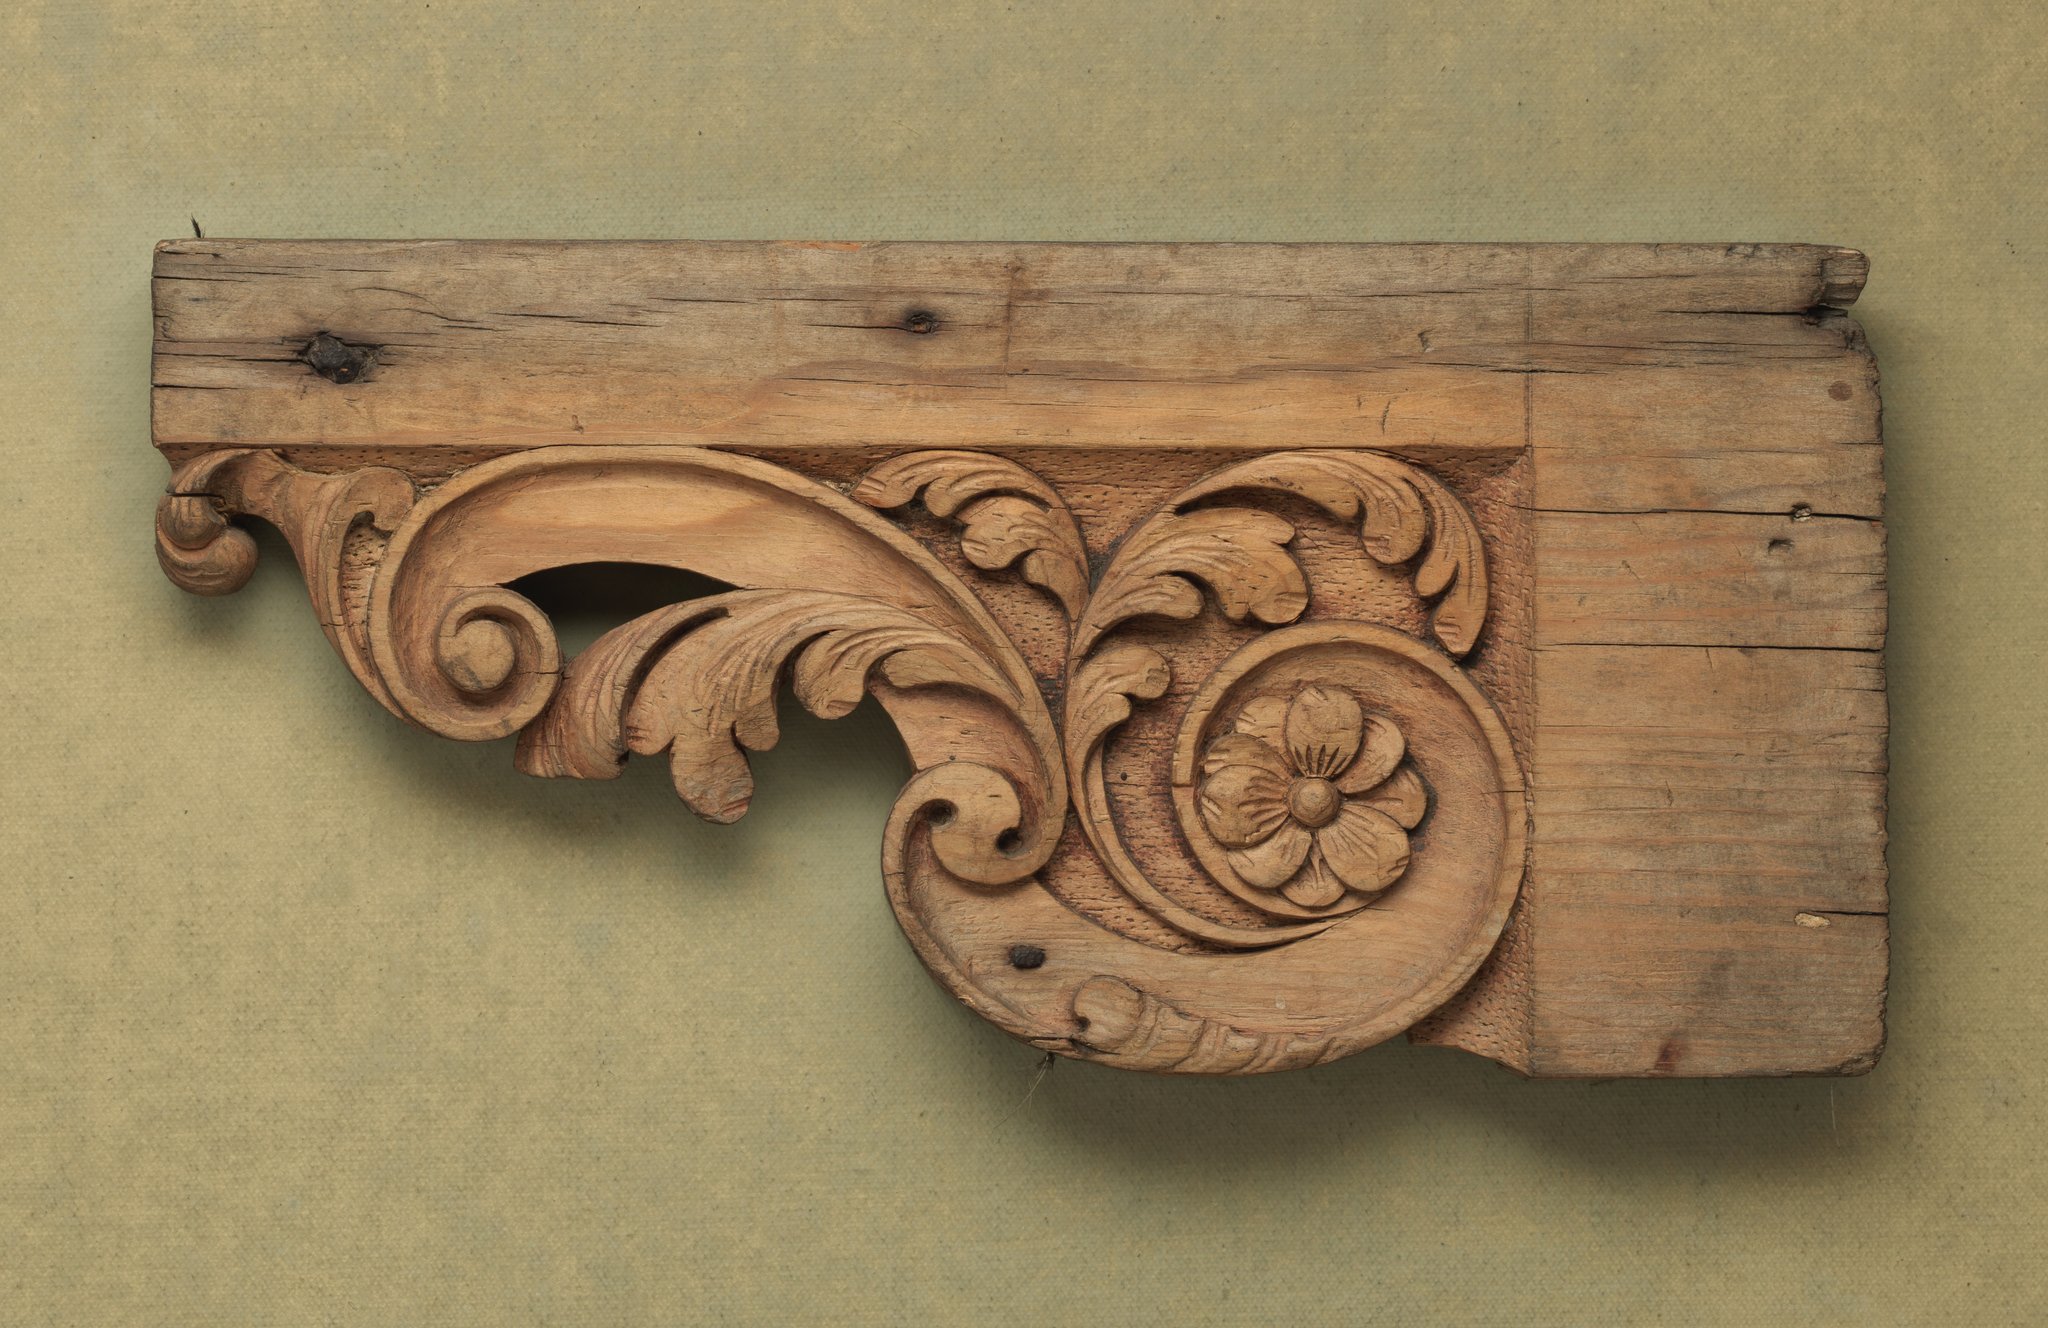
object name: bracket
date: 1701-1800